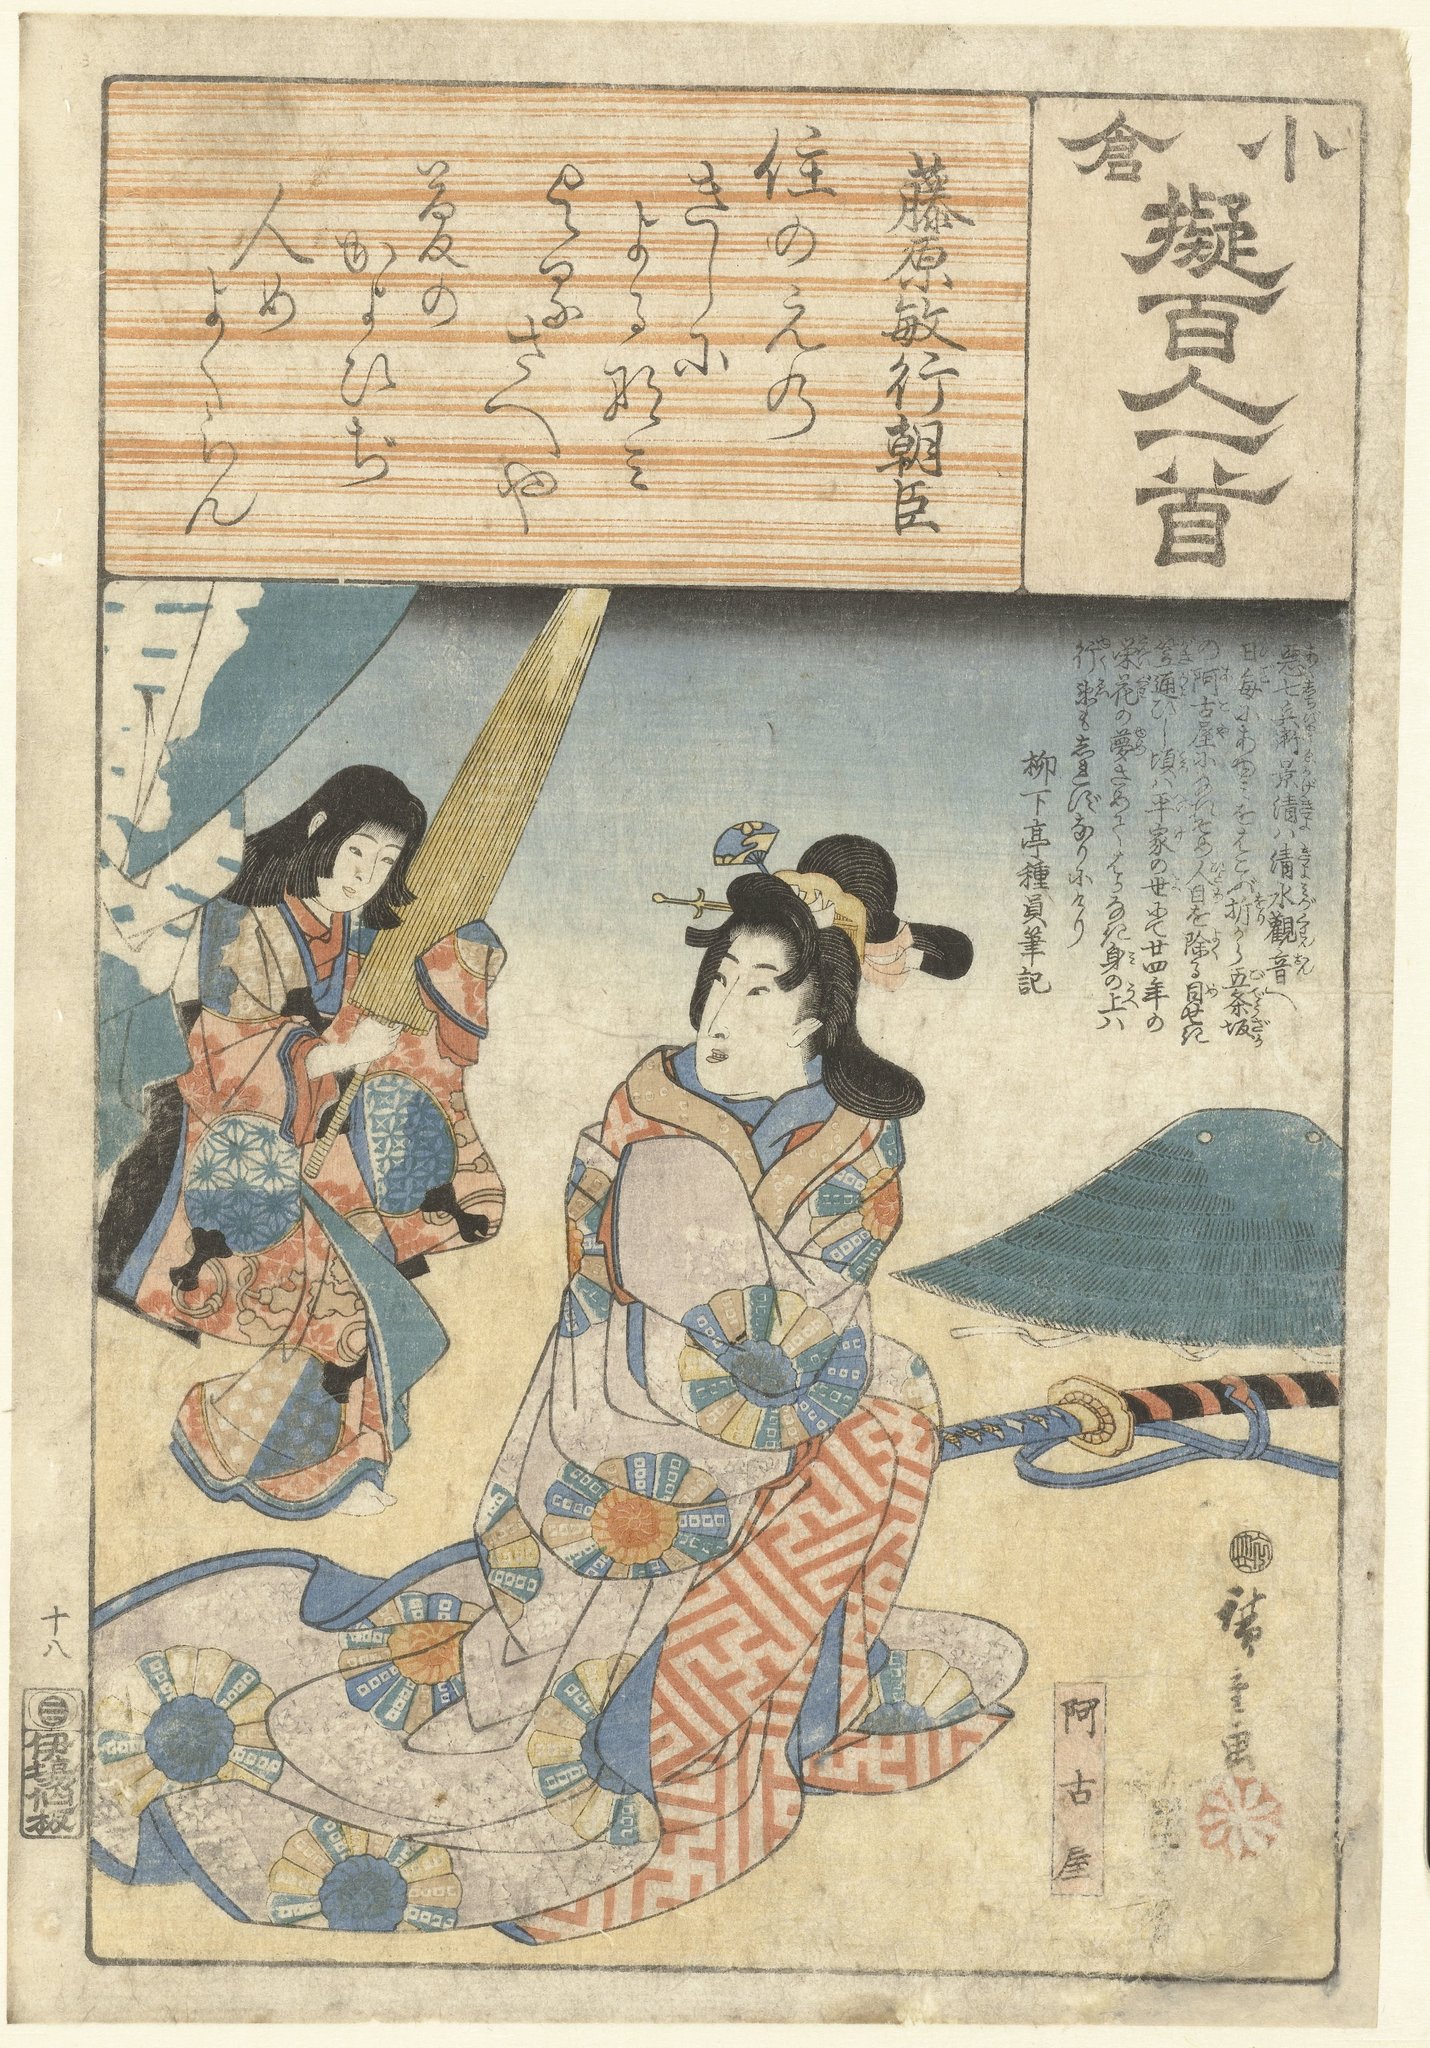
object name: print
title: Akoya met haar dienstmeisje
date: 1845-1846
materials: paper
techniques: woodcut, nishiki e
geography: japan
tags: sitting figure - aa - female human figure, parasol, sunshade, house personnel, servants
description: Vrouw, Akoya, zittend bij zwaard en rieten hoed (verwijzend naar haar geliefde Fujiwara no Kagekiyo), omkijkend naar dienstmeisje met parasol. Gedicht in oranje gestreept cartouche linksboven; boven hoed een commentaar op de voorstelling.